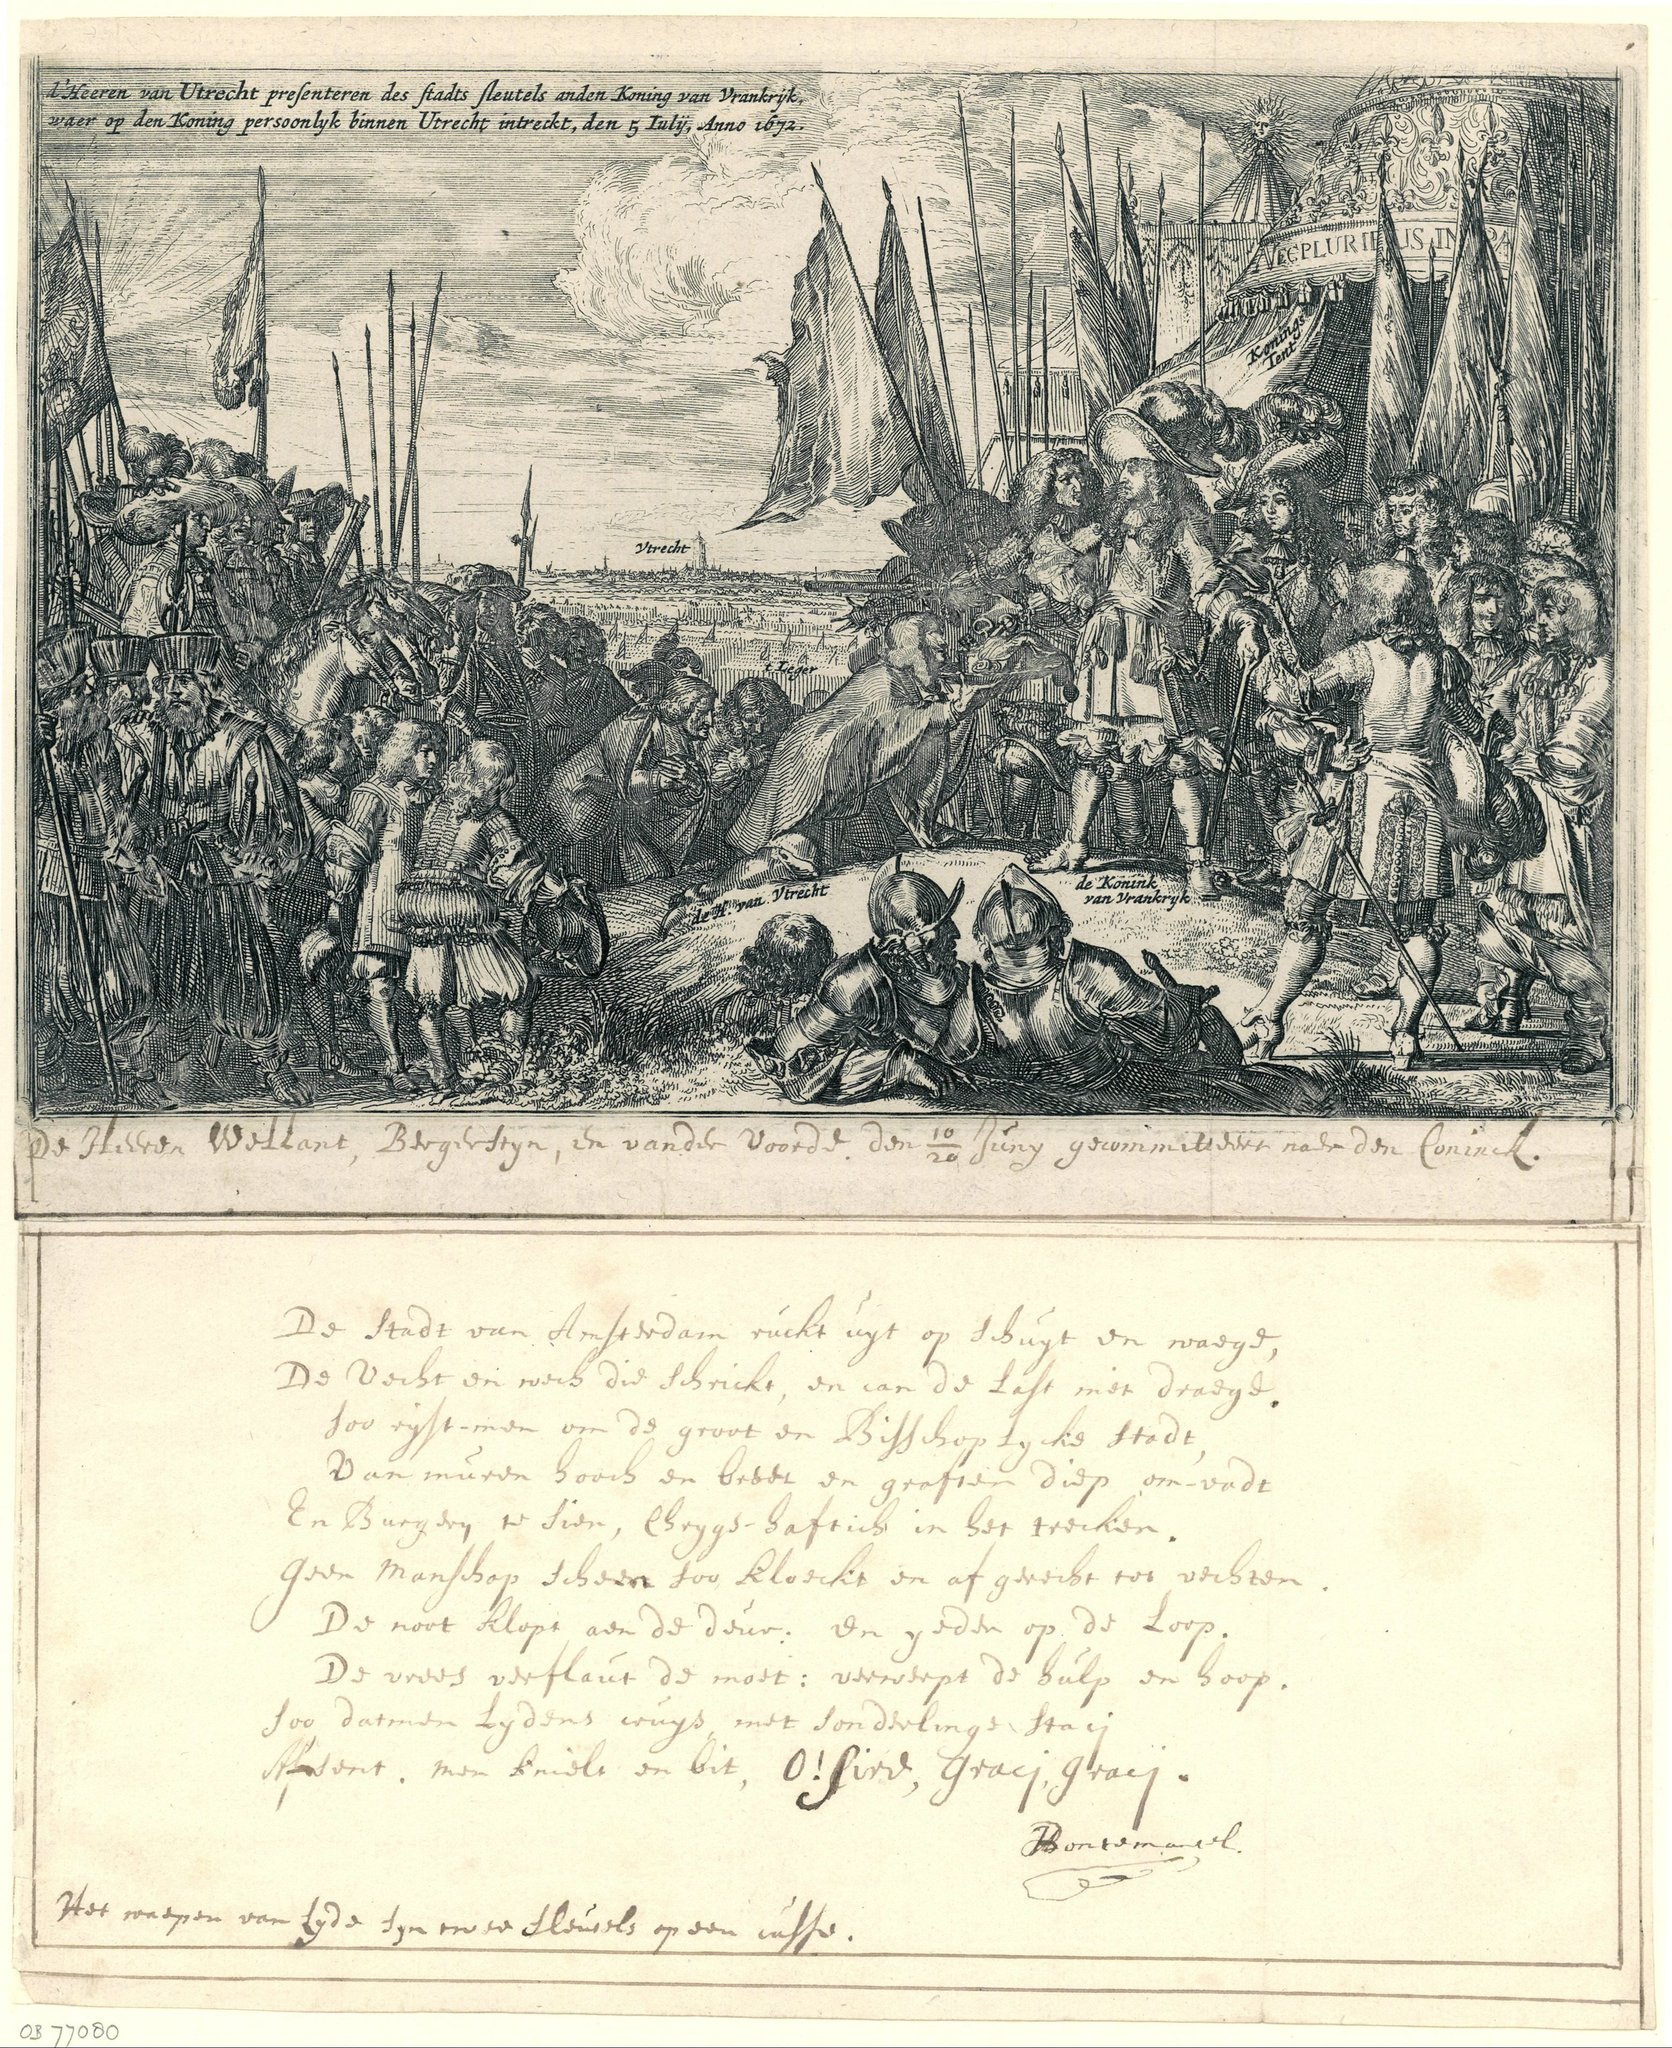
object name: history print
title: Stadsbestuur van Utrecht biedt Lodewijk XIV de sleutels van de stad aan, 1672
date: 1672-1674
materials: paper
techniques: engraving, etching, writing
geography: northern netherlands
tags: lodewijk xiv (koning van frankrijk), surrender of keys, utrecht, rampjaar (disaster year)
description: Het stadsbestuur van Utrecht overhandigt op 5 juli 1672 de sleutels van de stad aan Lodewijk XIV, koning van Frankrijk. Voorstelling van een fictieve gebeurtenis. Onder de voorstelling in pen een regel tekst en op een aangeplakt blad een vers van tien regels gesigneerd door Bontemantel.